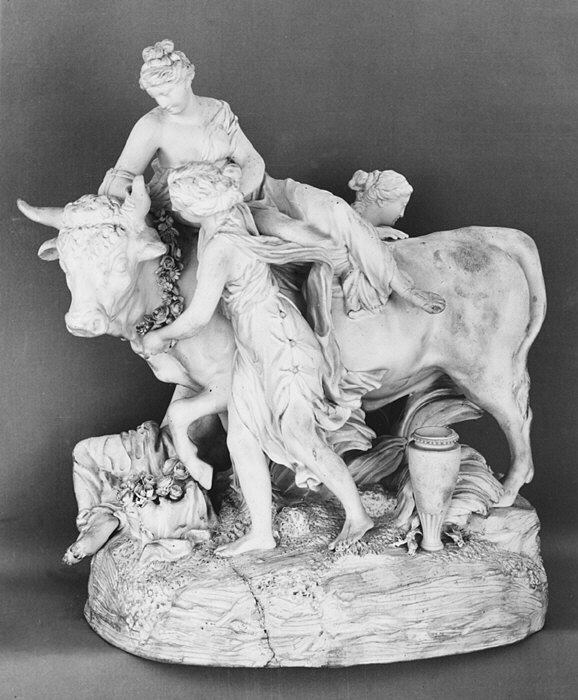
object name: group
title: Europa and the Bull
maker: meissen manufactory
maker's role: manufactory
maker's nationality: german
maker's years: 1710-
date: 1701-1900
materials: biscuit, porcelain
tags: women,bulls